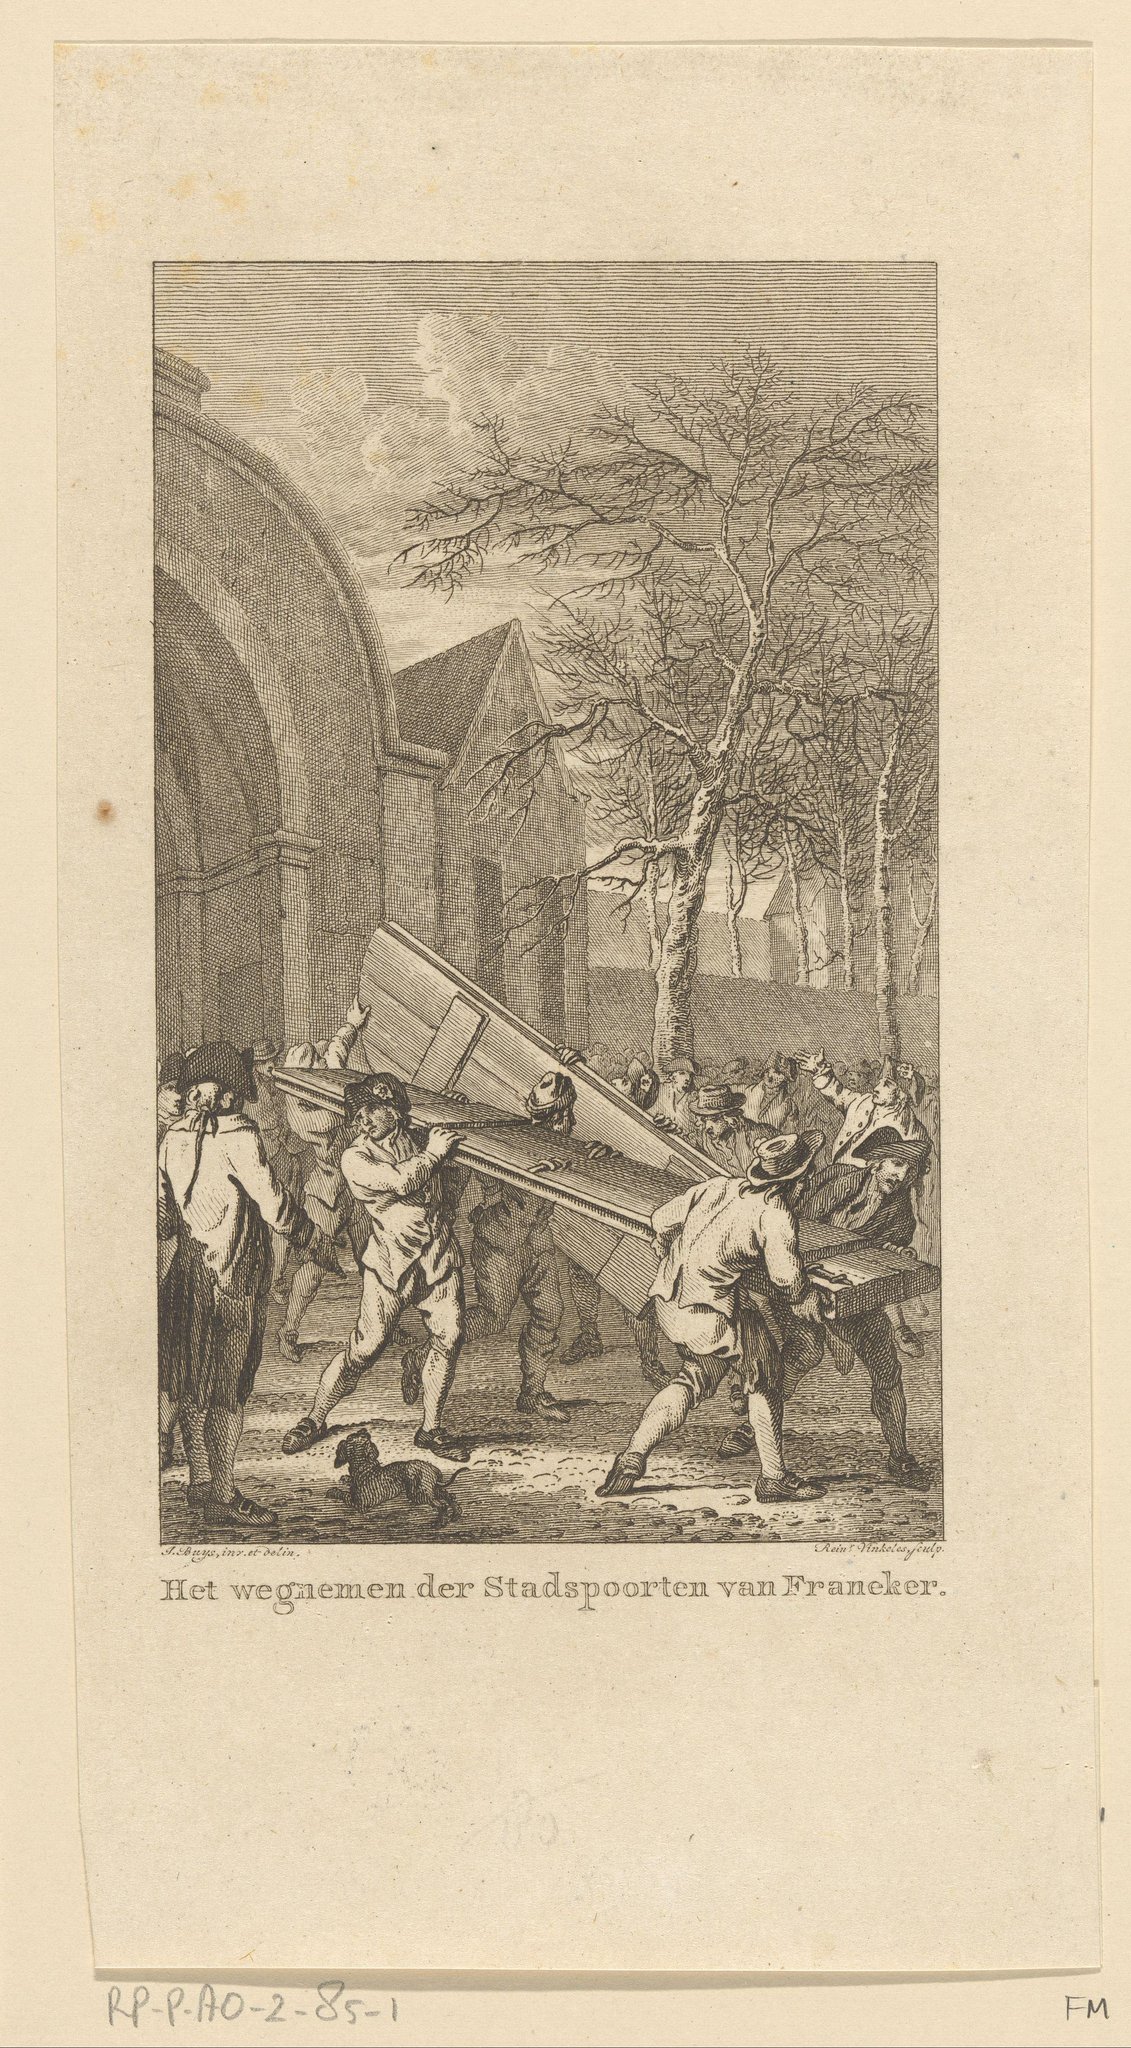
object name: history print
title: Wegnemen van de deuren van de stadspoort te Franeker, 1788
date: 1797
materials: paper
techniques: engraving, etching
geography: amsterdam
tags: franeker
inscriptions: collector's mark: Lugt 2228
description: Gebruikt als illustratie in: P.A. Loosjes. Vaderlandsche historie, vervattende de geschiedenissen, der Vereenigde Nederlanden (...). Ten onmiddelyken vervolge van Wagenaar's Vaderlandsche historie. Amsterdam: Johannes Allart, dl. 19 (1797).